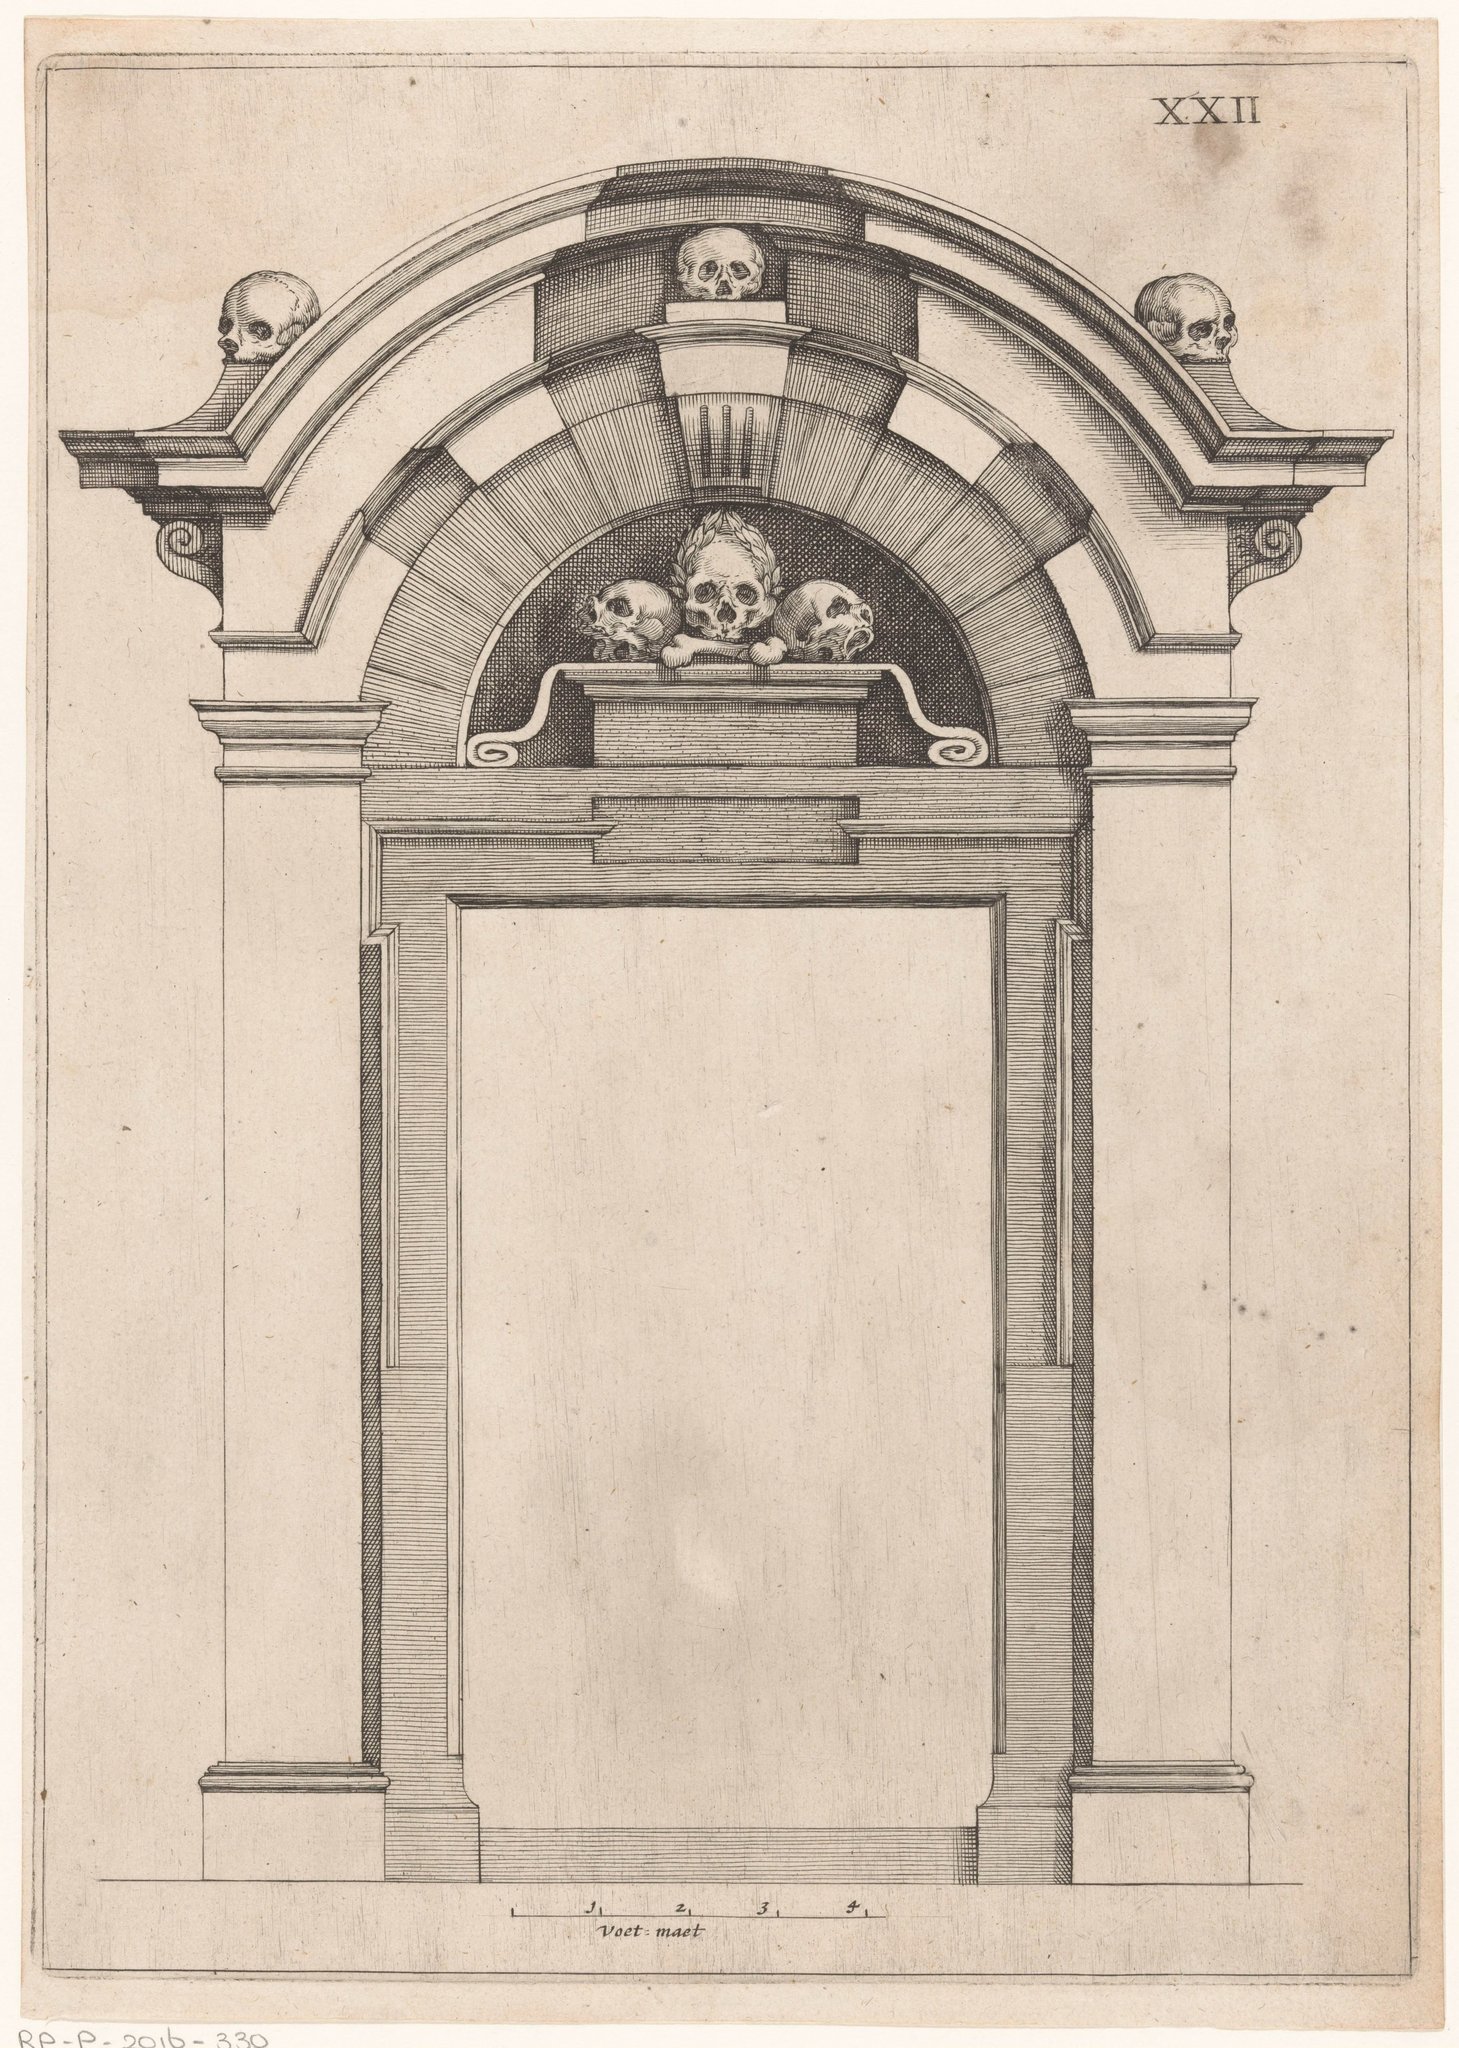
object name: print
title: Architectura moderna ofte Bouwinge van onsen tyt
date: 1631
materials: paper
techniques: engraving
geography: amsterdam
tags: churchyard, cemetery, plan ~ architecture, exterior ~ architectural design or model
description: Prent uit: Keyser, Hendrick de. Architectura moderna ofte bouwinge van onsen tyt (...) alle gedaen by (...) Amsterdam: Danckerts, Cornelis, 1631.